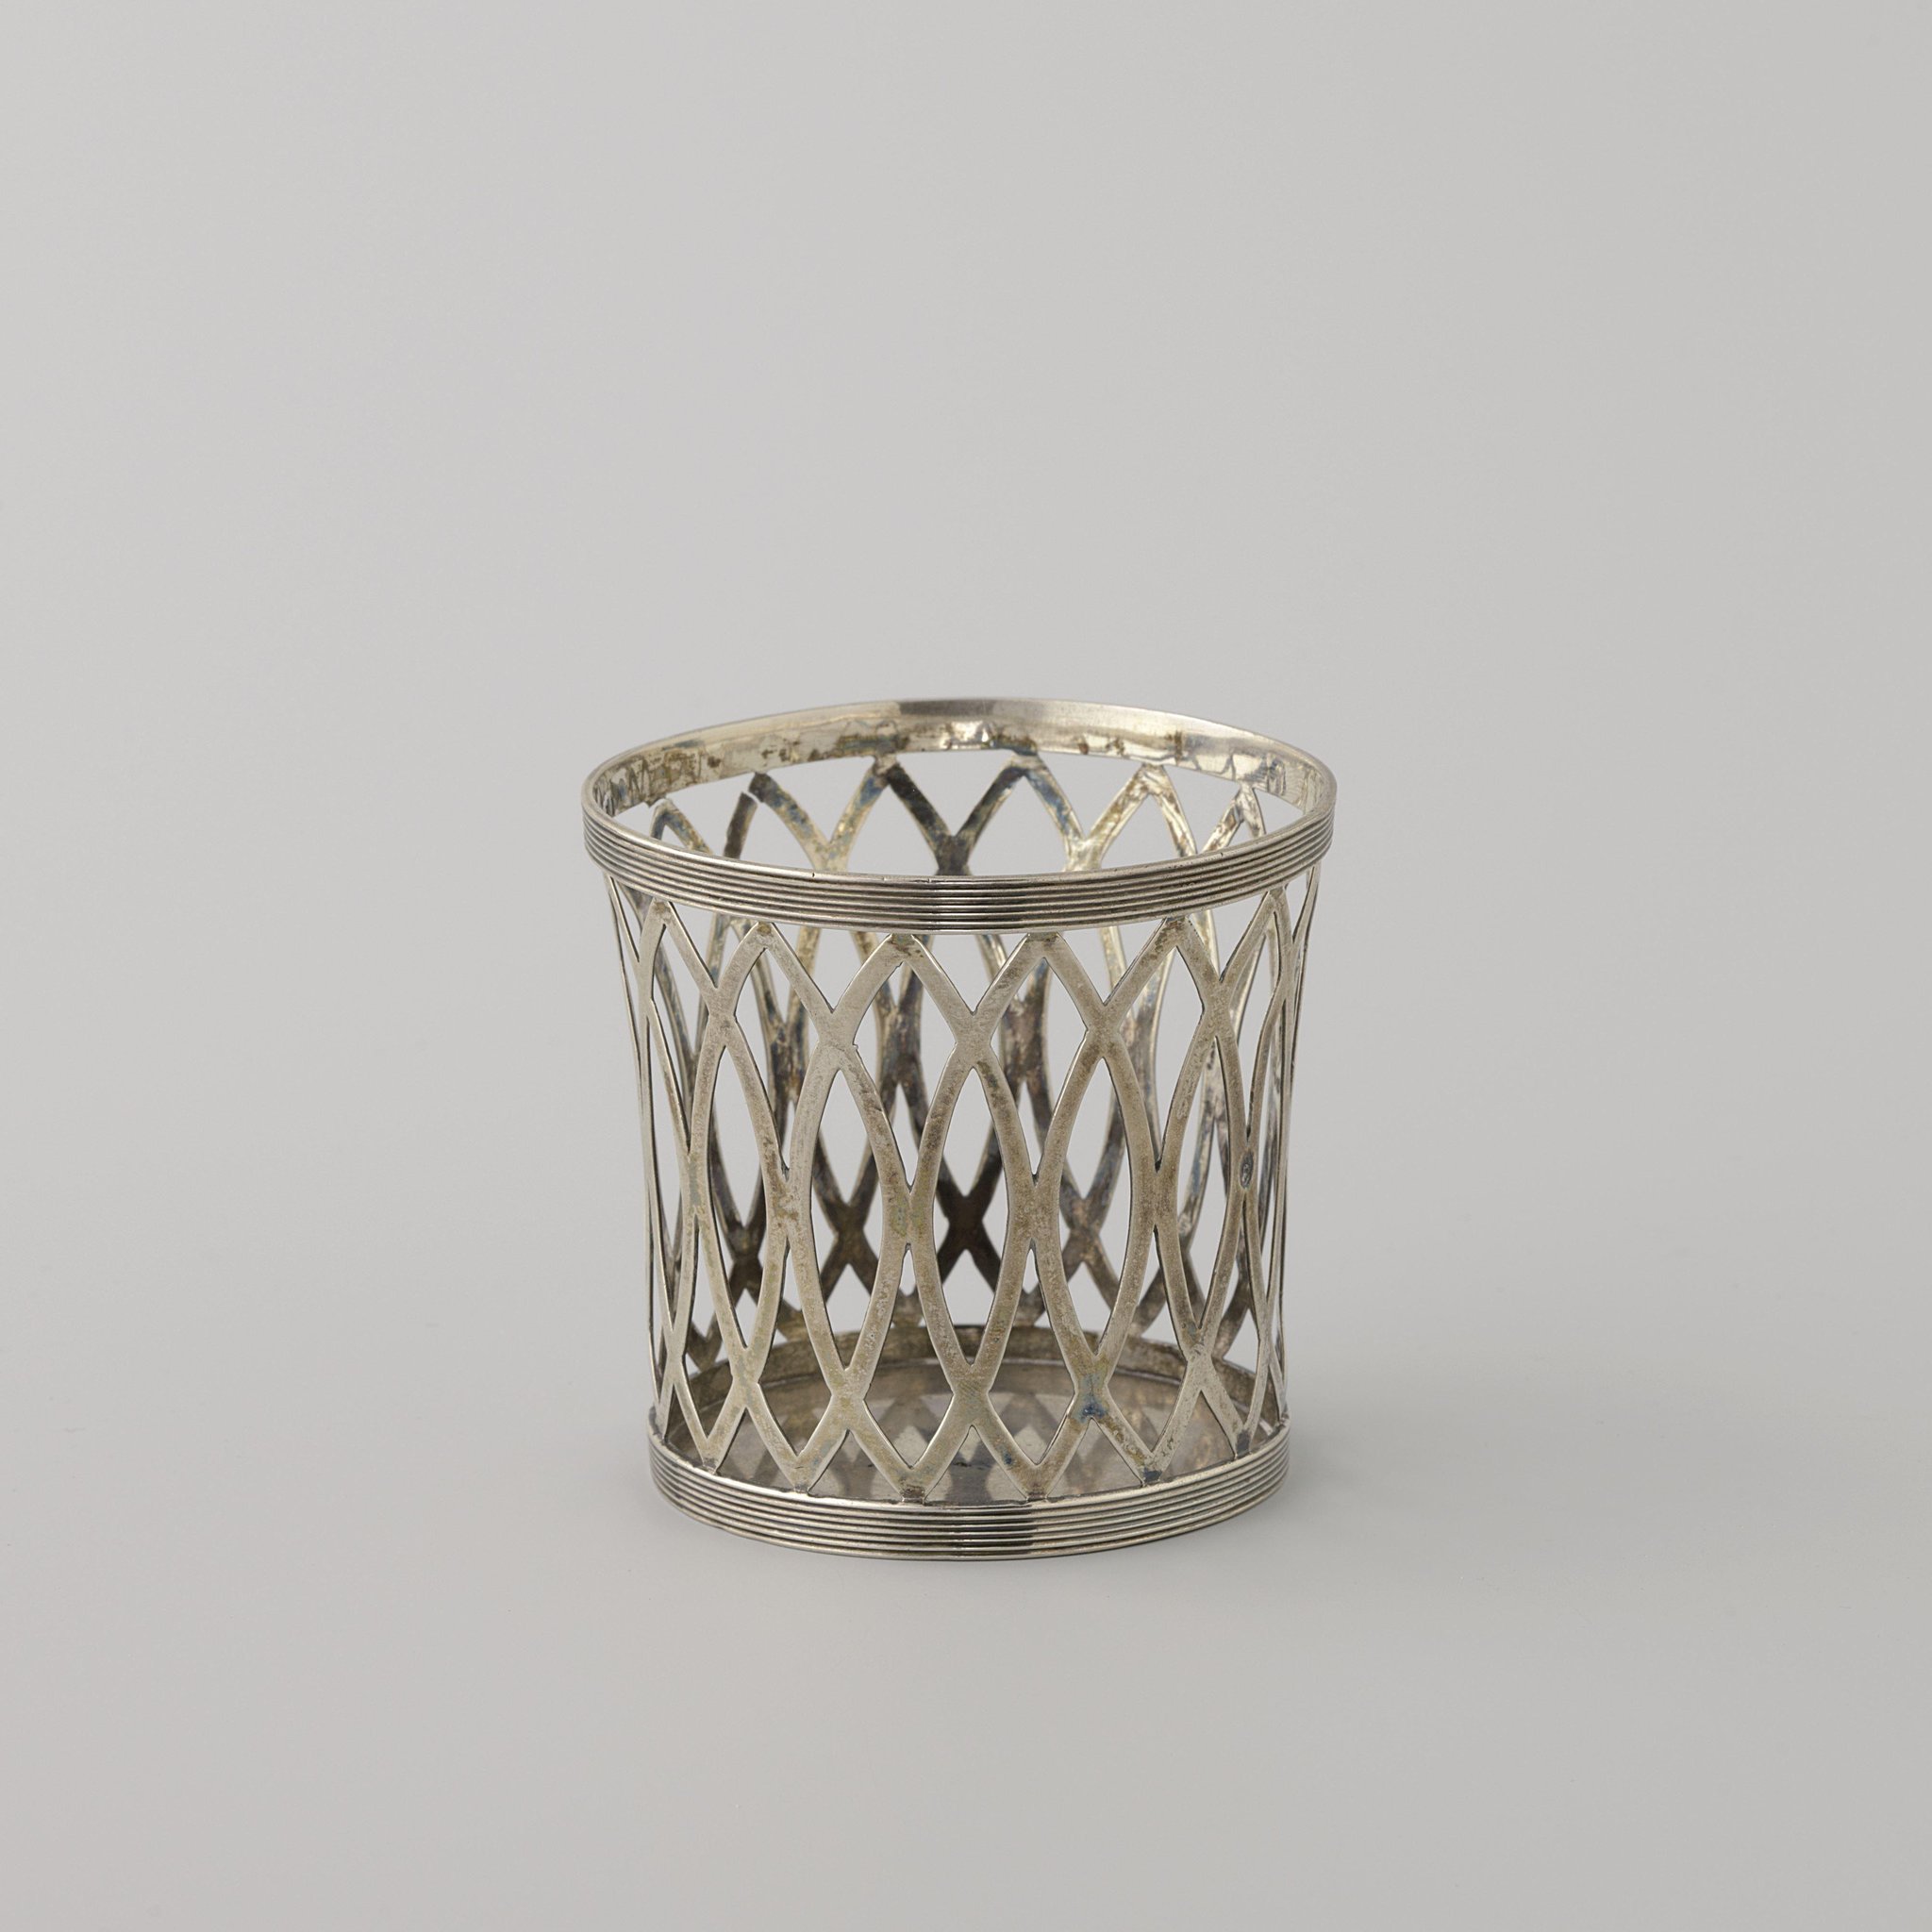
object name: basket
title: Twee kleine (B en D) en twee grotere (A en C) manden of houders, à jour bewerkt met dooreengeslingerde ovalen en filetranden langs onder- en bovenzijde.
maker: Anonymous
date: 1800-1825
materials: silver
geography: netherlands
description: Twee kleine (B en D) en twee grotere (A en C) manden of houders, à jour bewerkt met dooreengeslingerde ovalen en filetranden langs onder- en bovenzijde. Nederland?, eerste kwart 19de eeuw. Gemerkt op buitenzijde wand: herkeur zwaard.